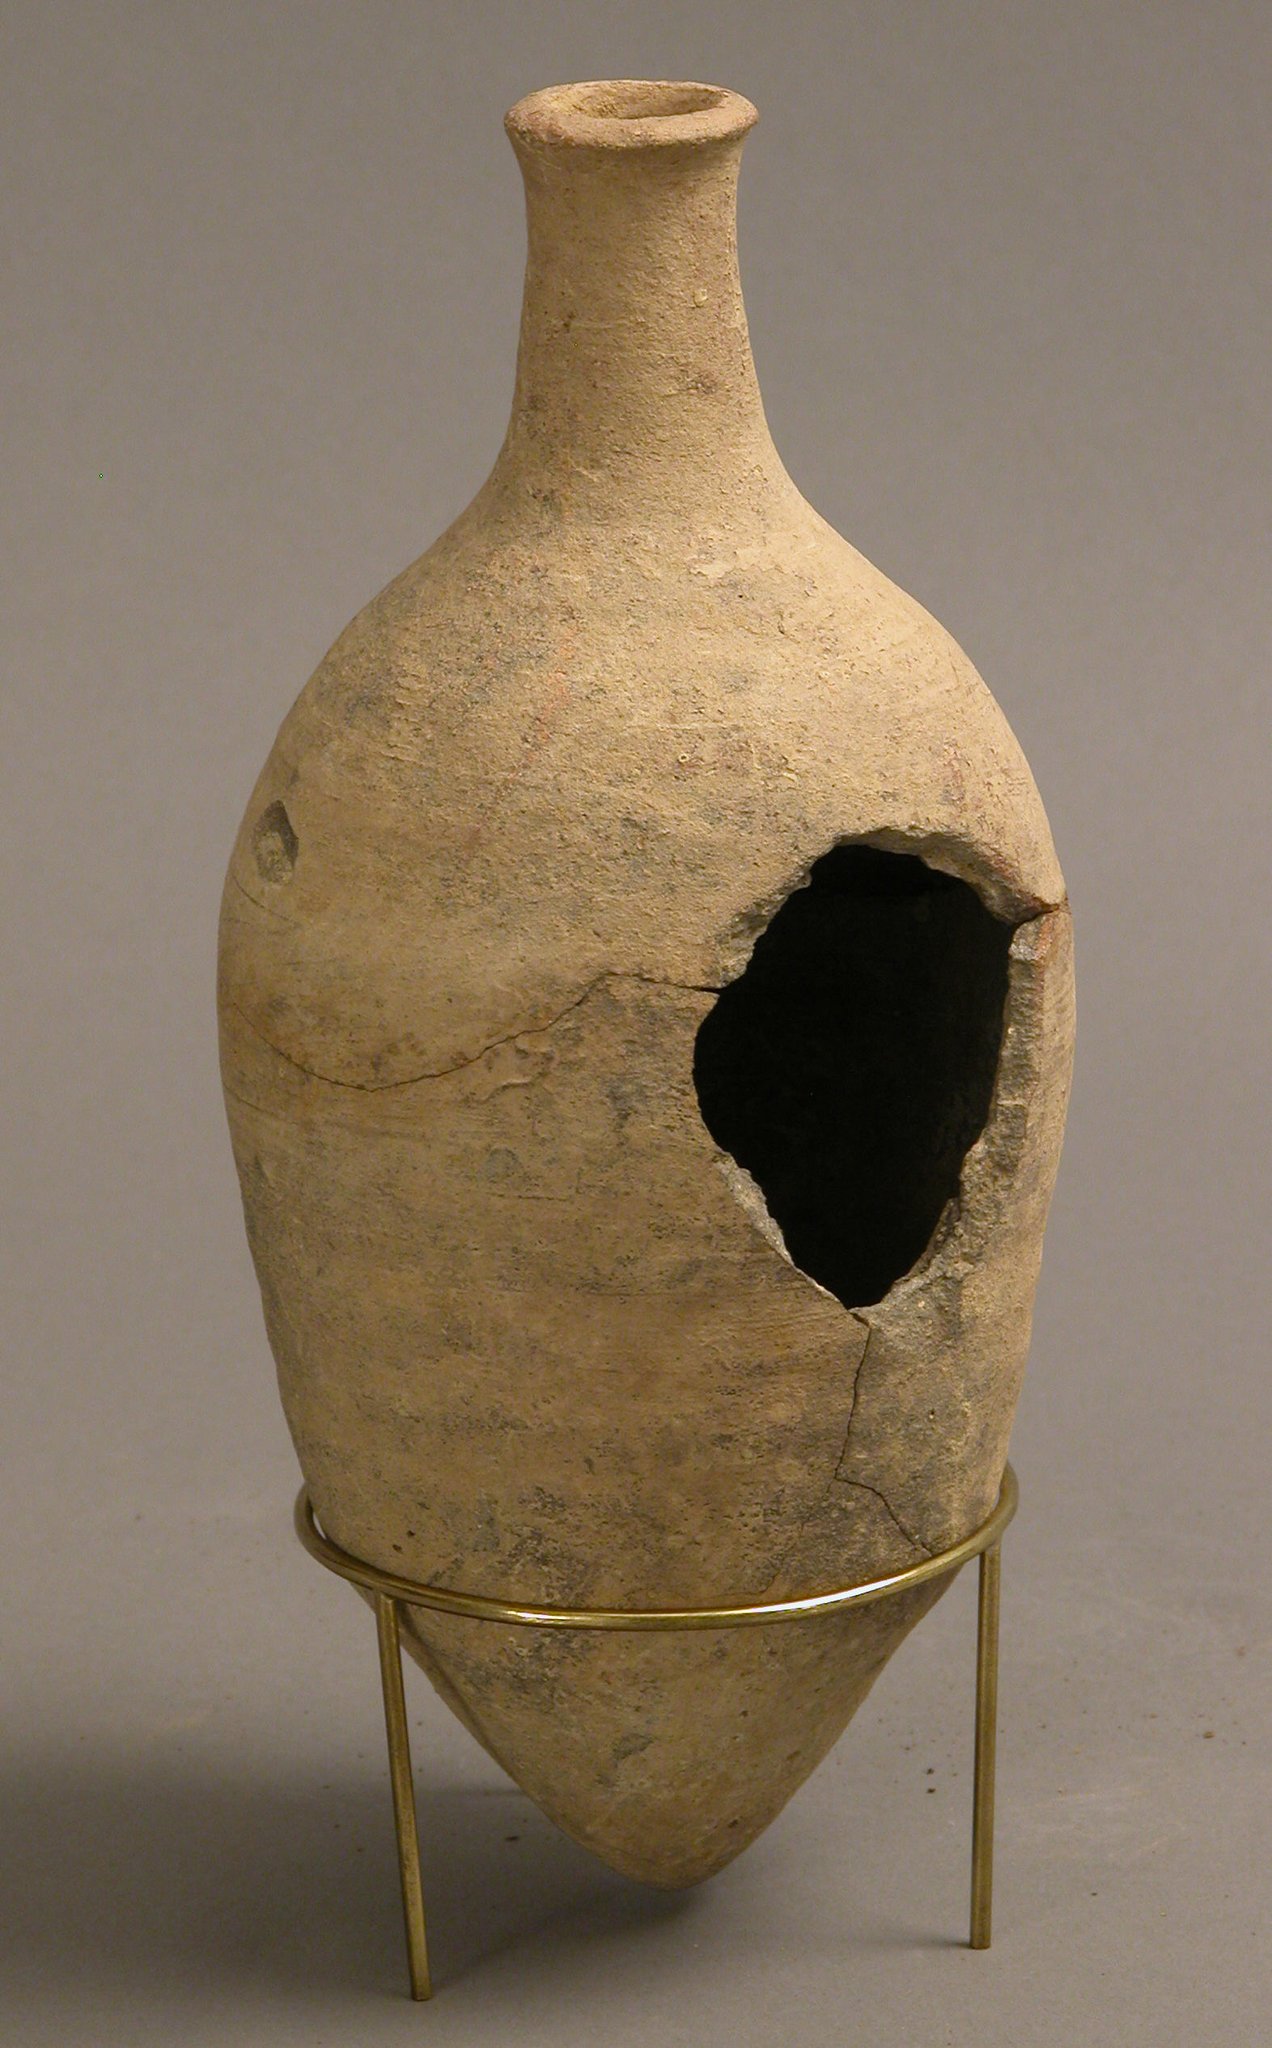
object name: jug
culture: coptic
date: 301-700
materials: earthenware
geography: egypt